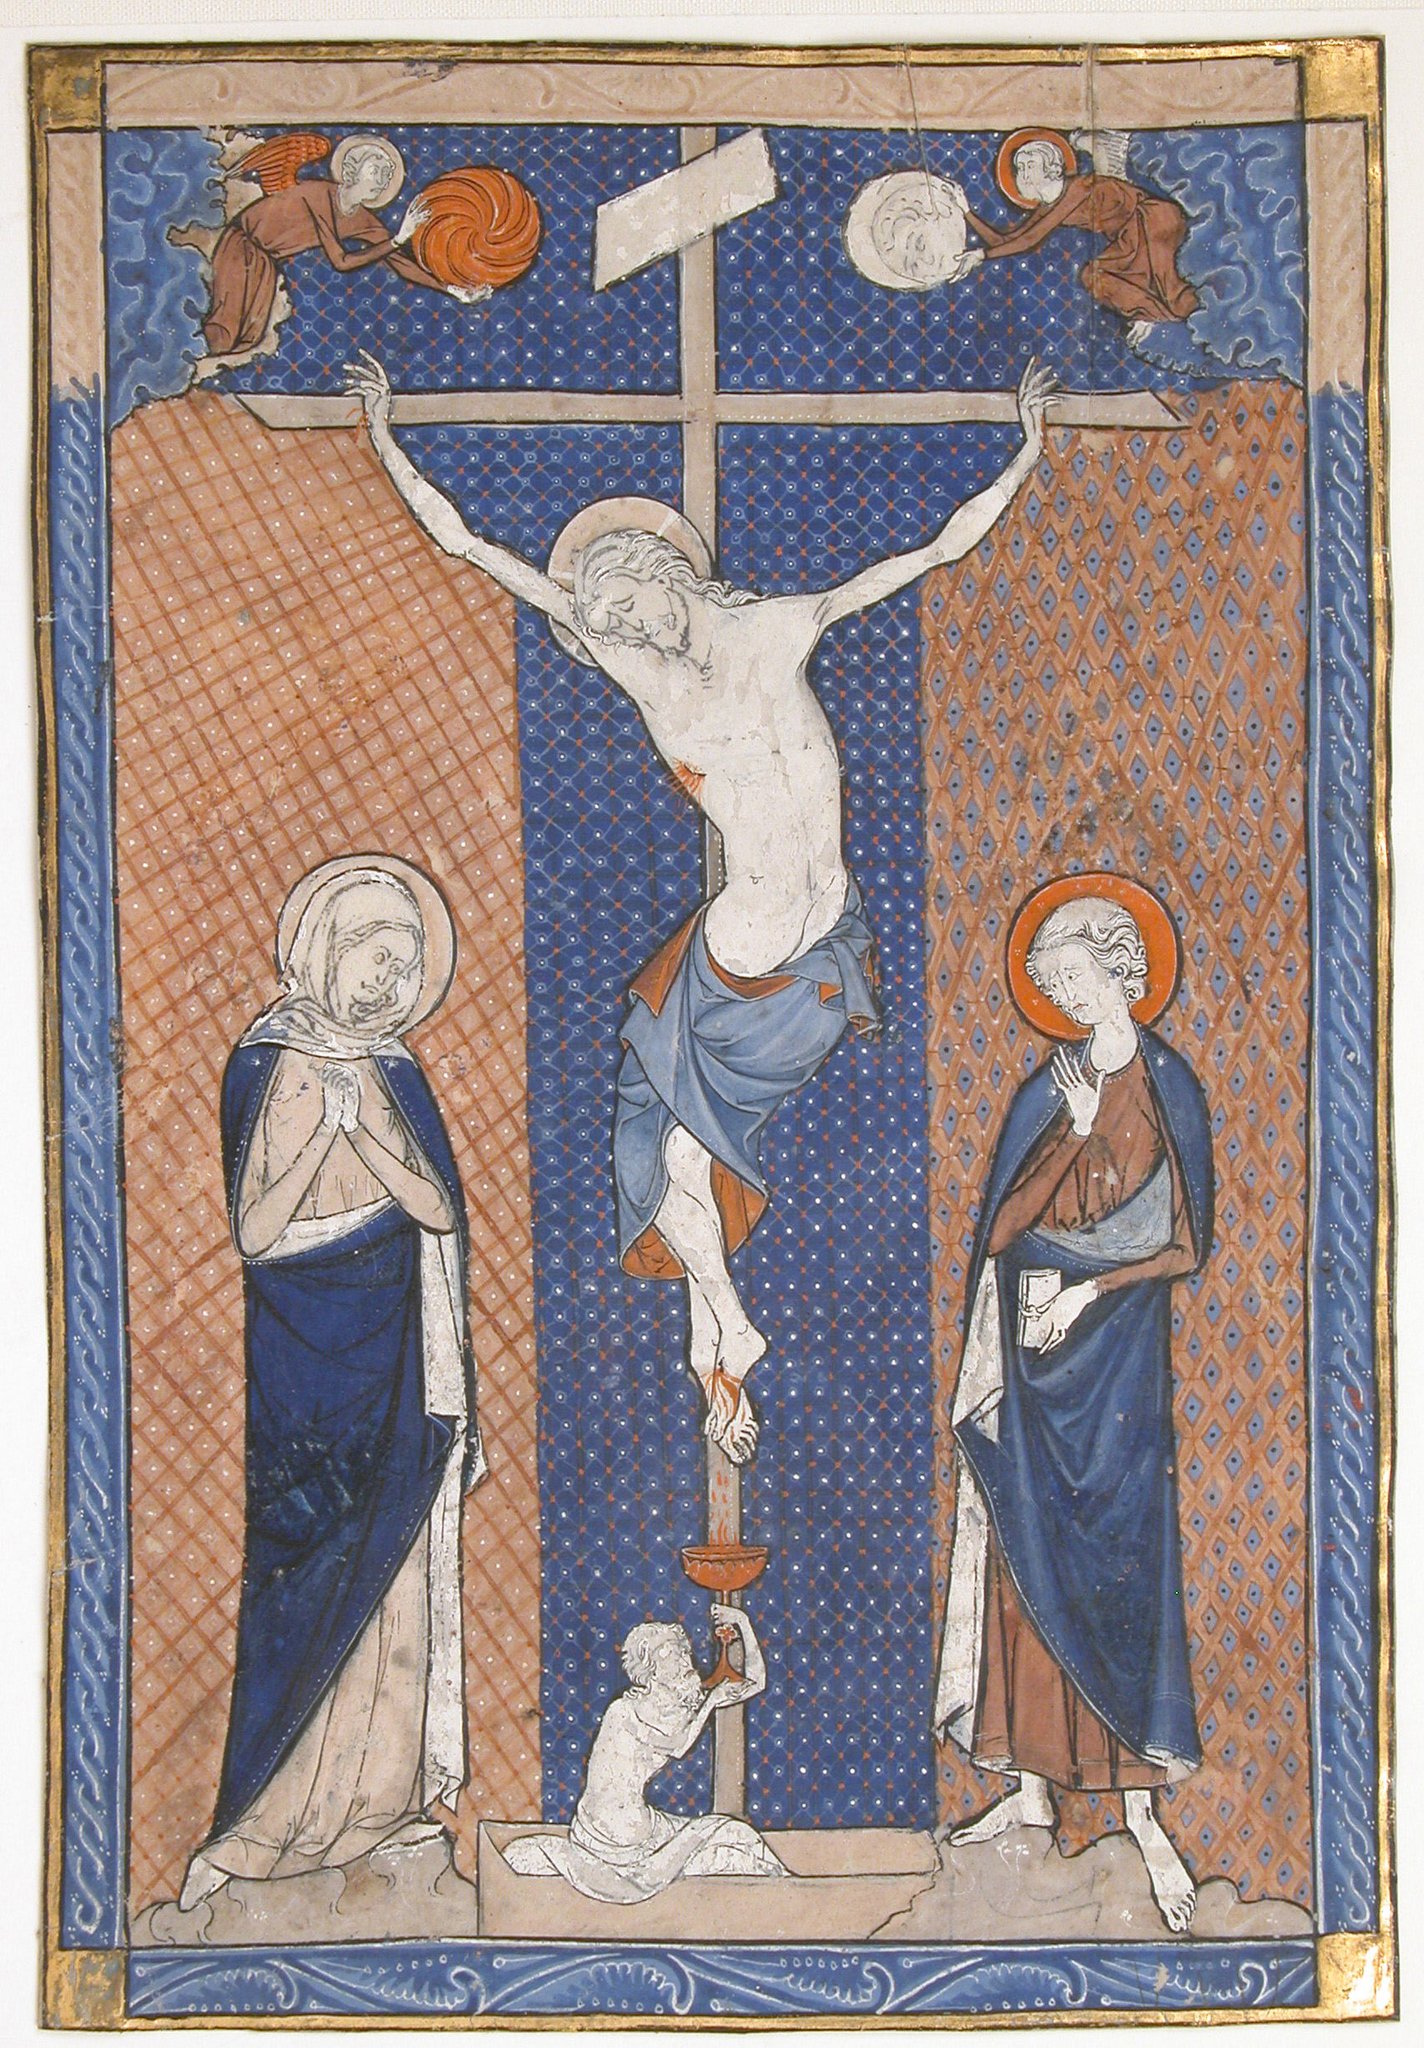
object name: missal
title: Manuscript Leaf with the Crucifixion, from a Missal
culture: french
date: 1270-1280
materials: gold, parchment, paint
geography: france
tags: angels,christ,saint john the evangelist,virgin mary,crucifixion